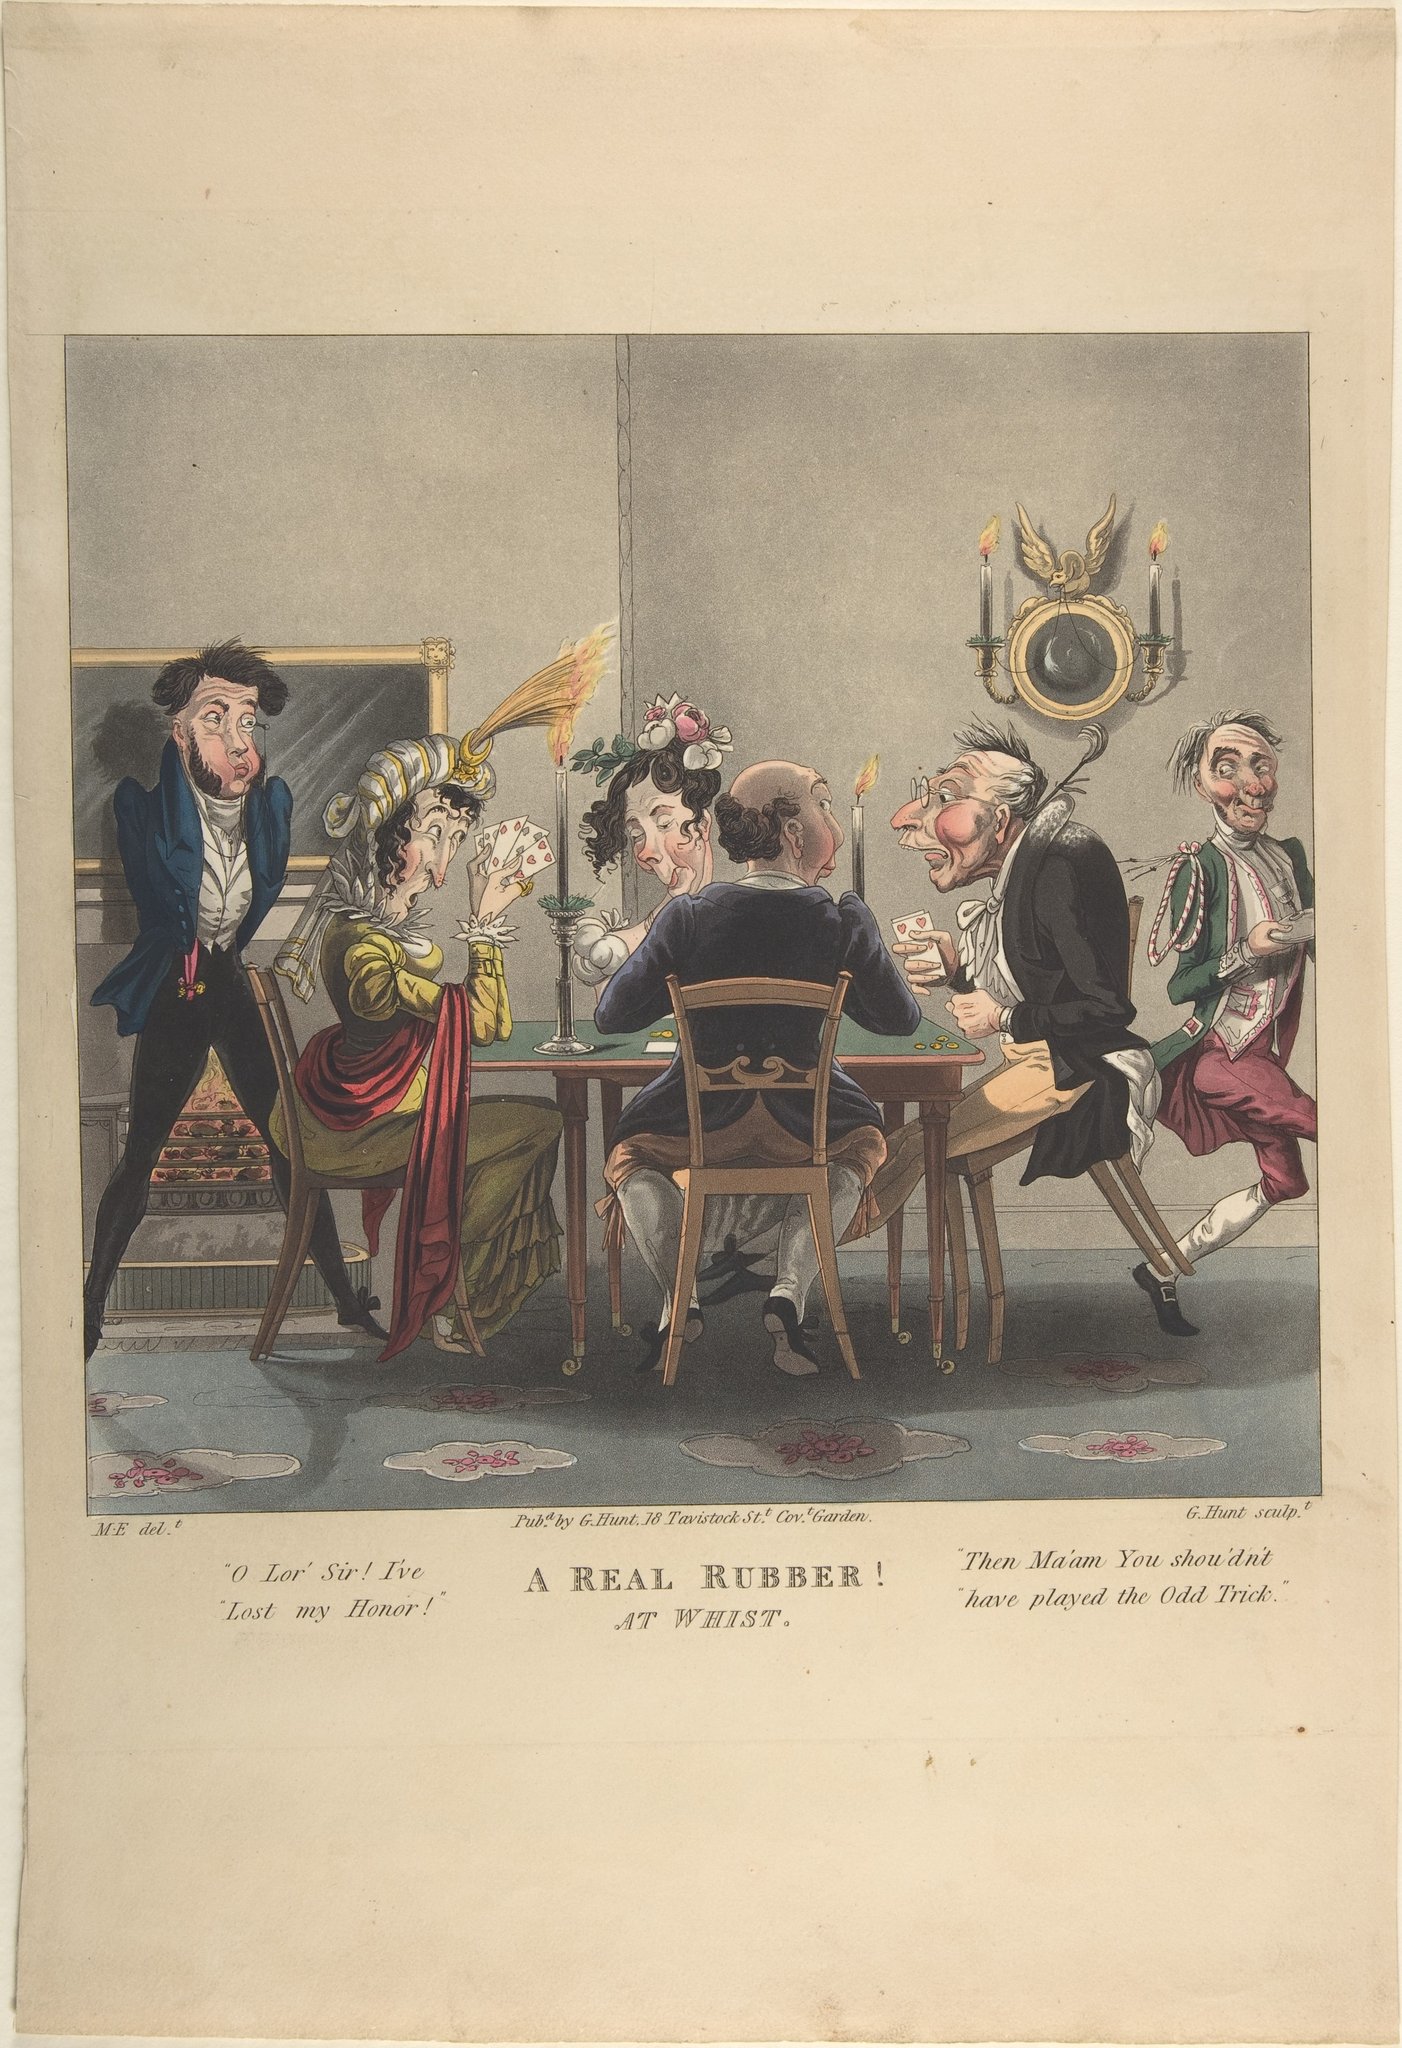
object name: print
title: A Real Rubber! At Whist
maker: george hunt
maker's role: artist and publisher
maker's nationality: british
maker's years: 1800-1850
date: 1825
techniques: aquatint, etching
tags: men,women,playing,playing cards